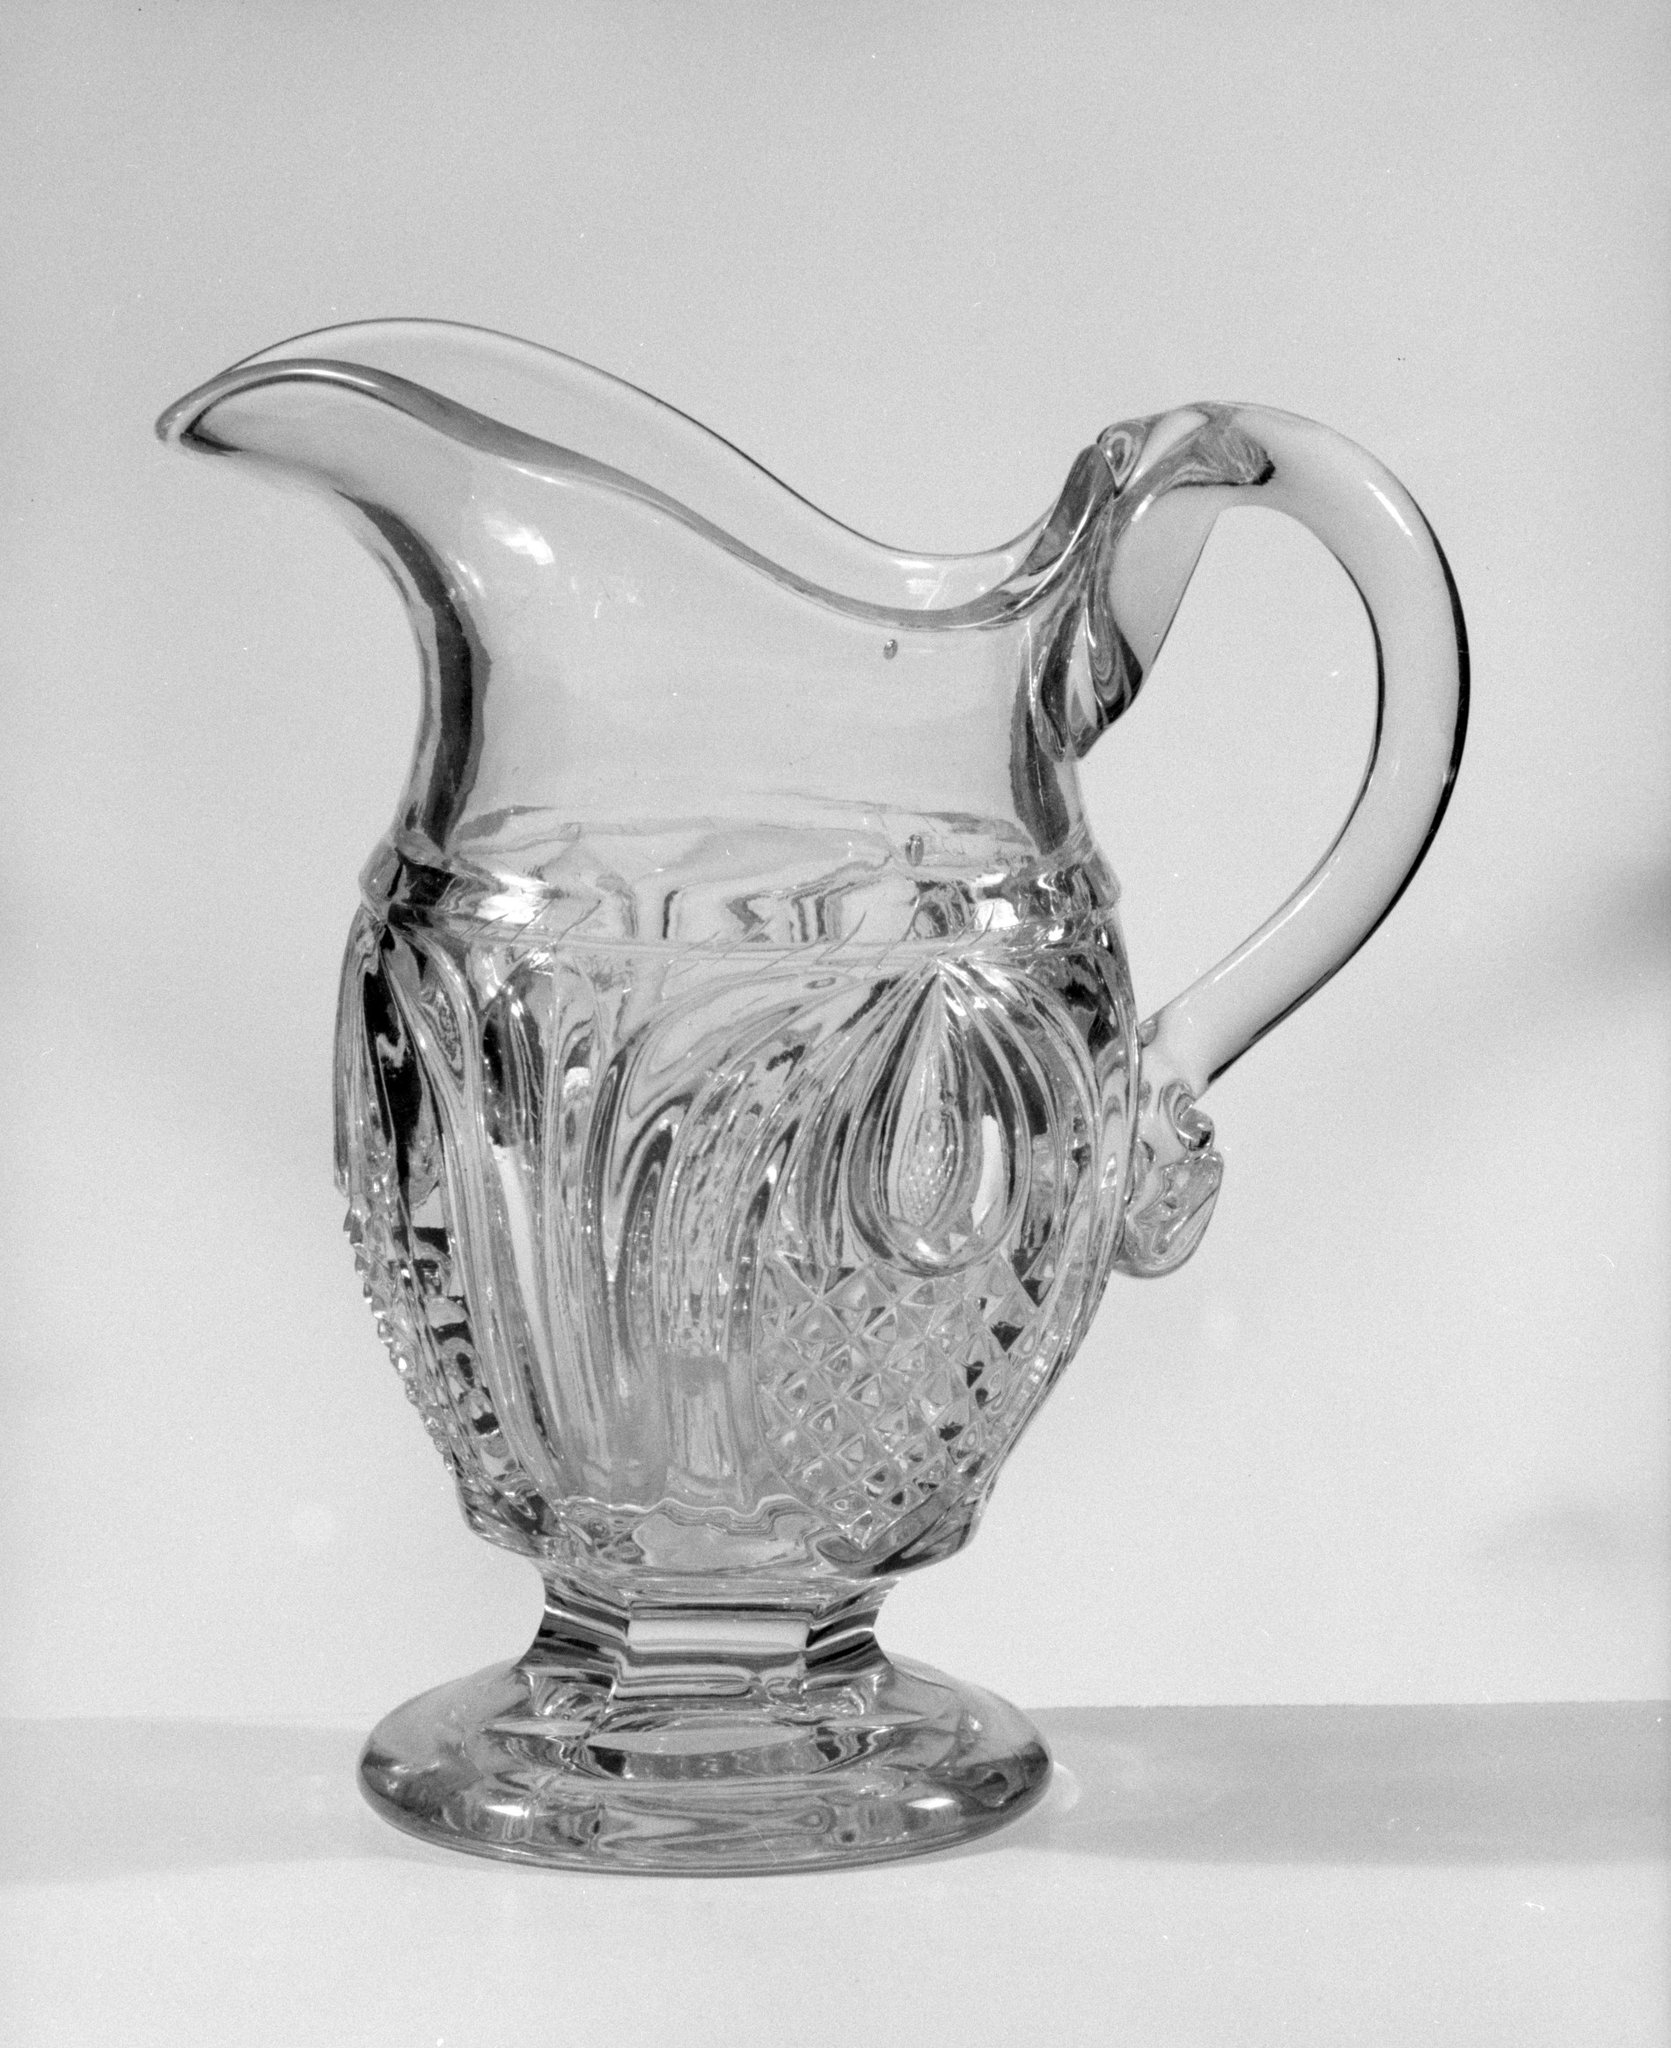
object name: pitcher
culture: american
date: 1850-1870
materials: glass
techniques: pressed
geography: united states